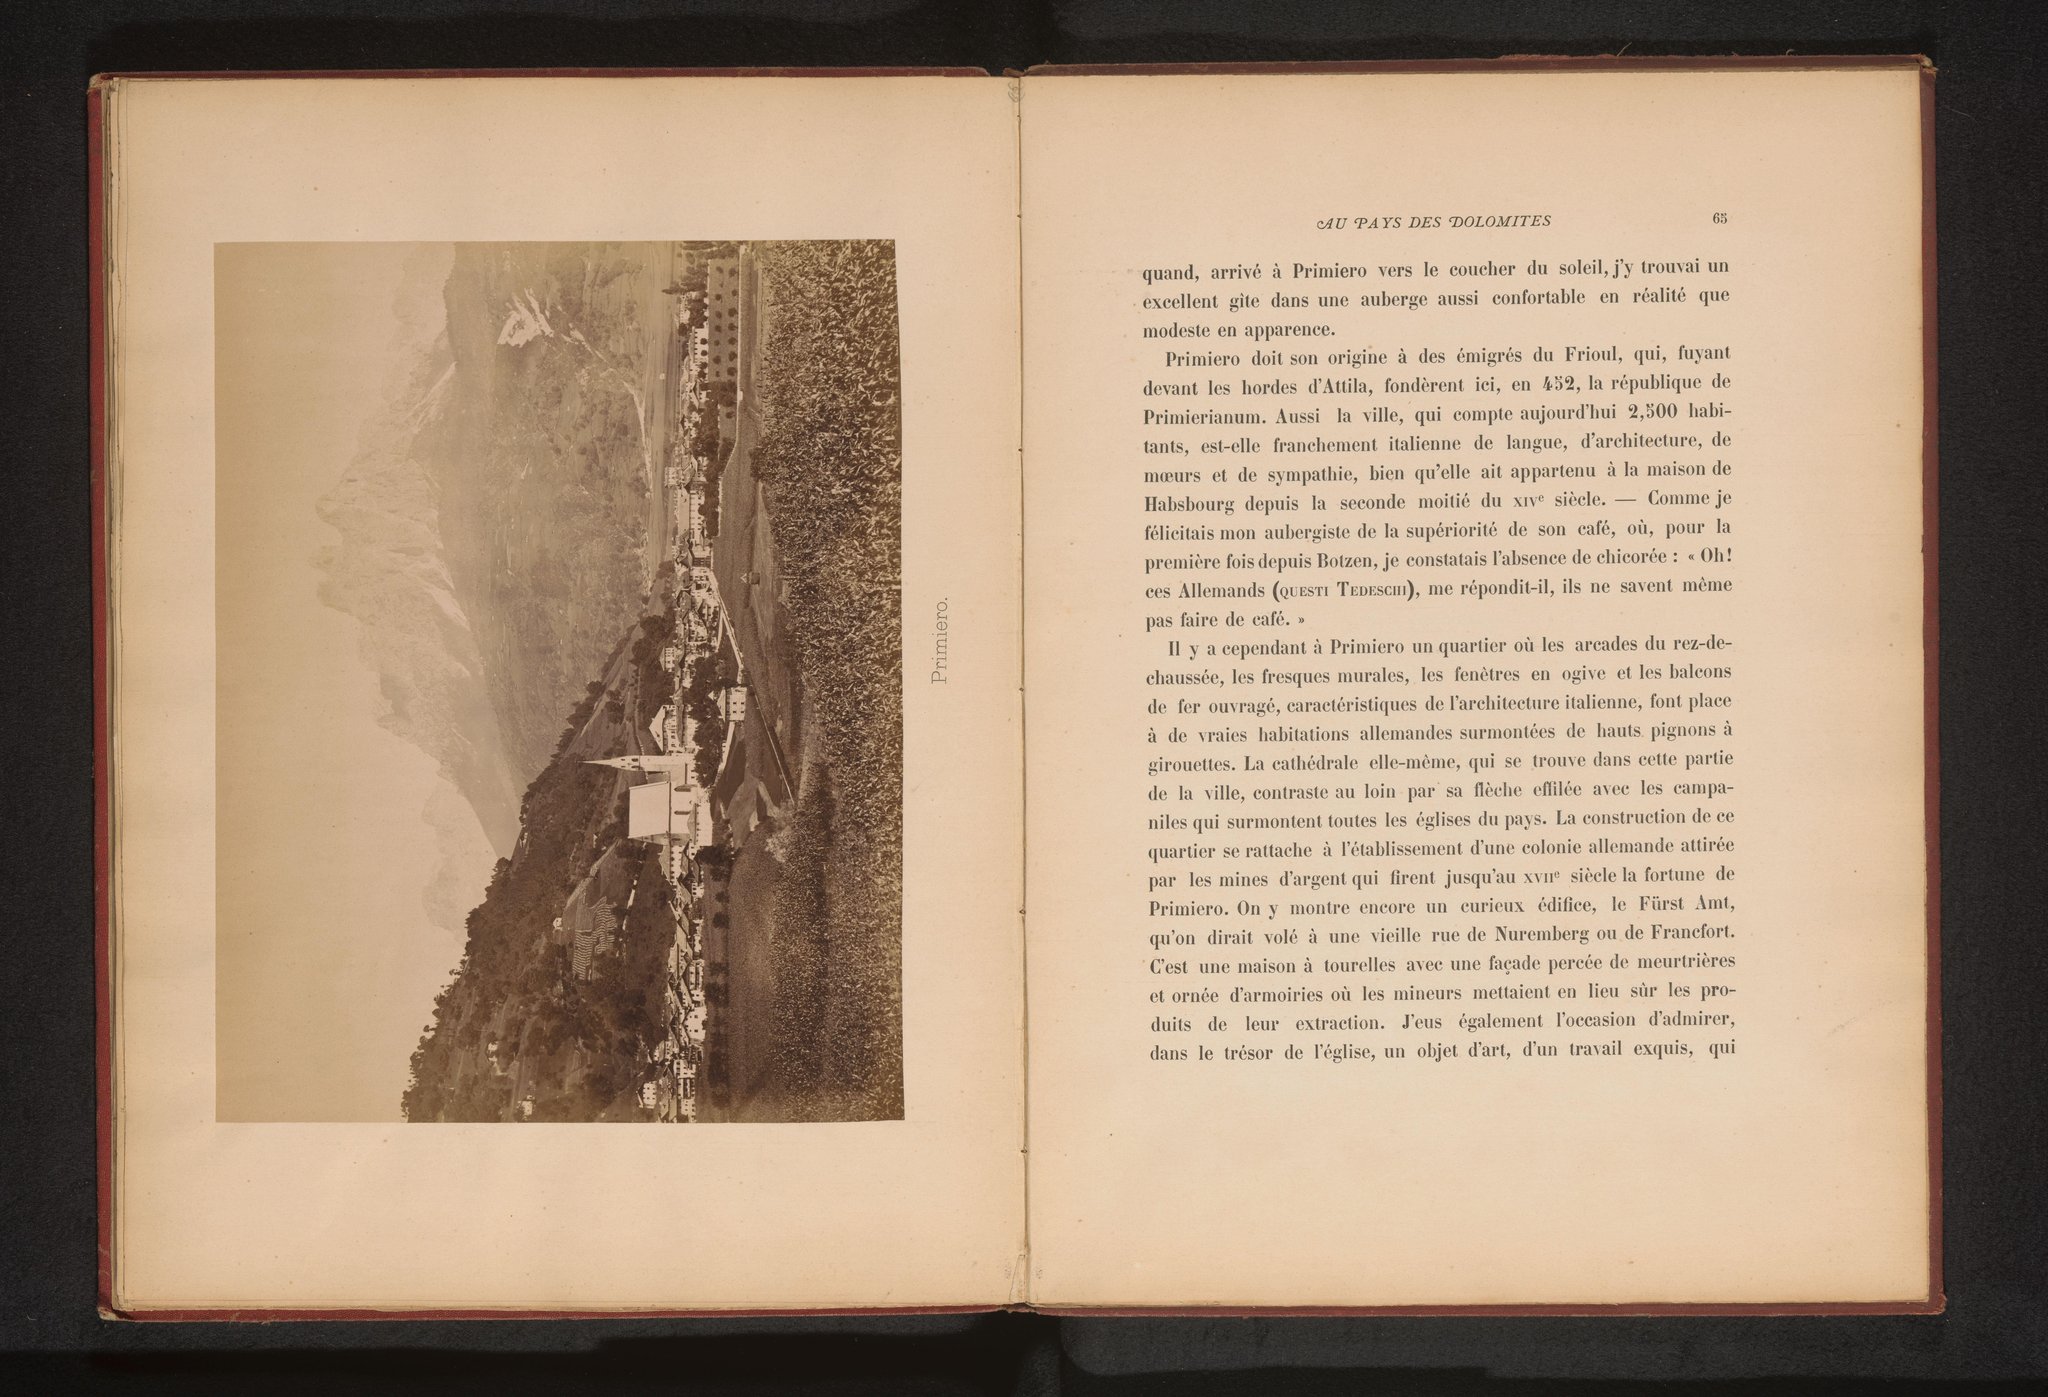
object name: page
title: Gezicht op Valle di Primiero in de Dolomieten, Italië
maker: eugène goblet dalviella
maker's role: politician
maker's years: 1846-1925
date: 1873-1878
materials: photographic support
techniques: albumen print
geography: dolomites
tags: prospect of village, silhouette of village, dale, valley, mountains